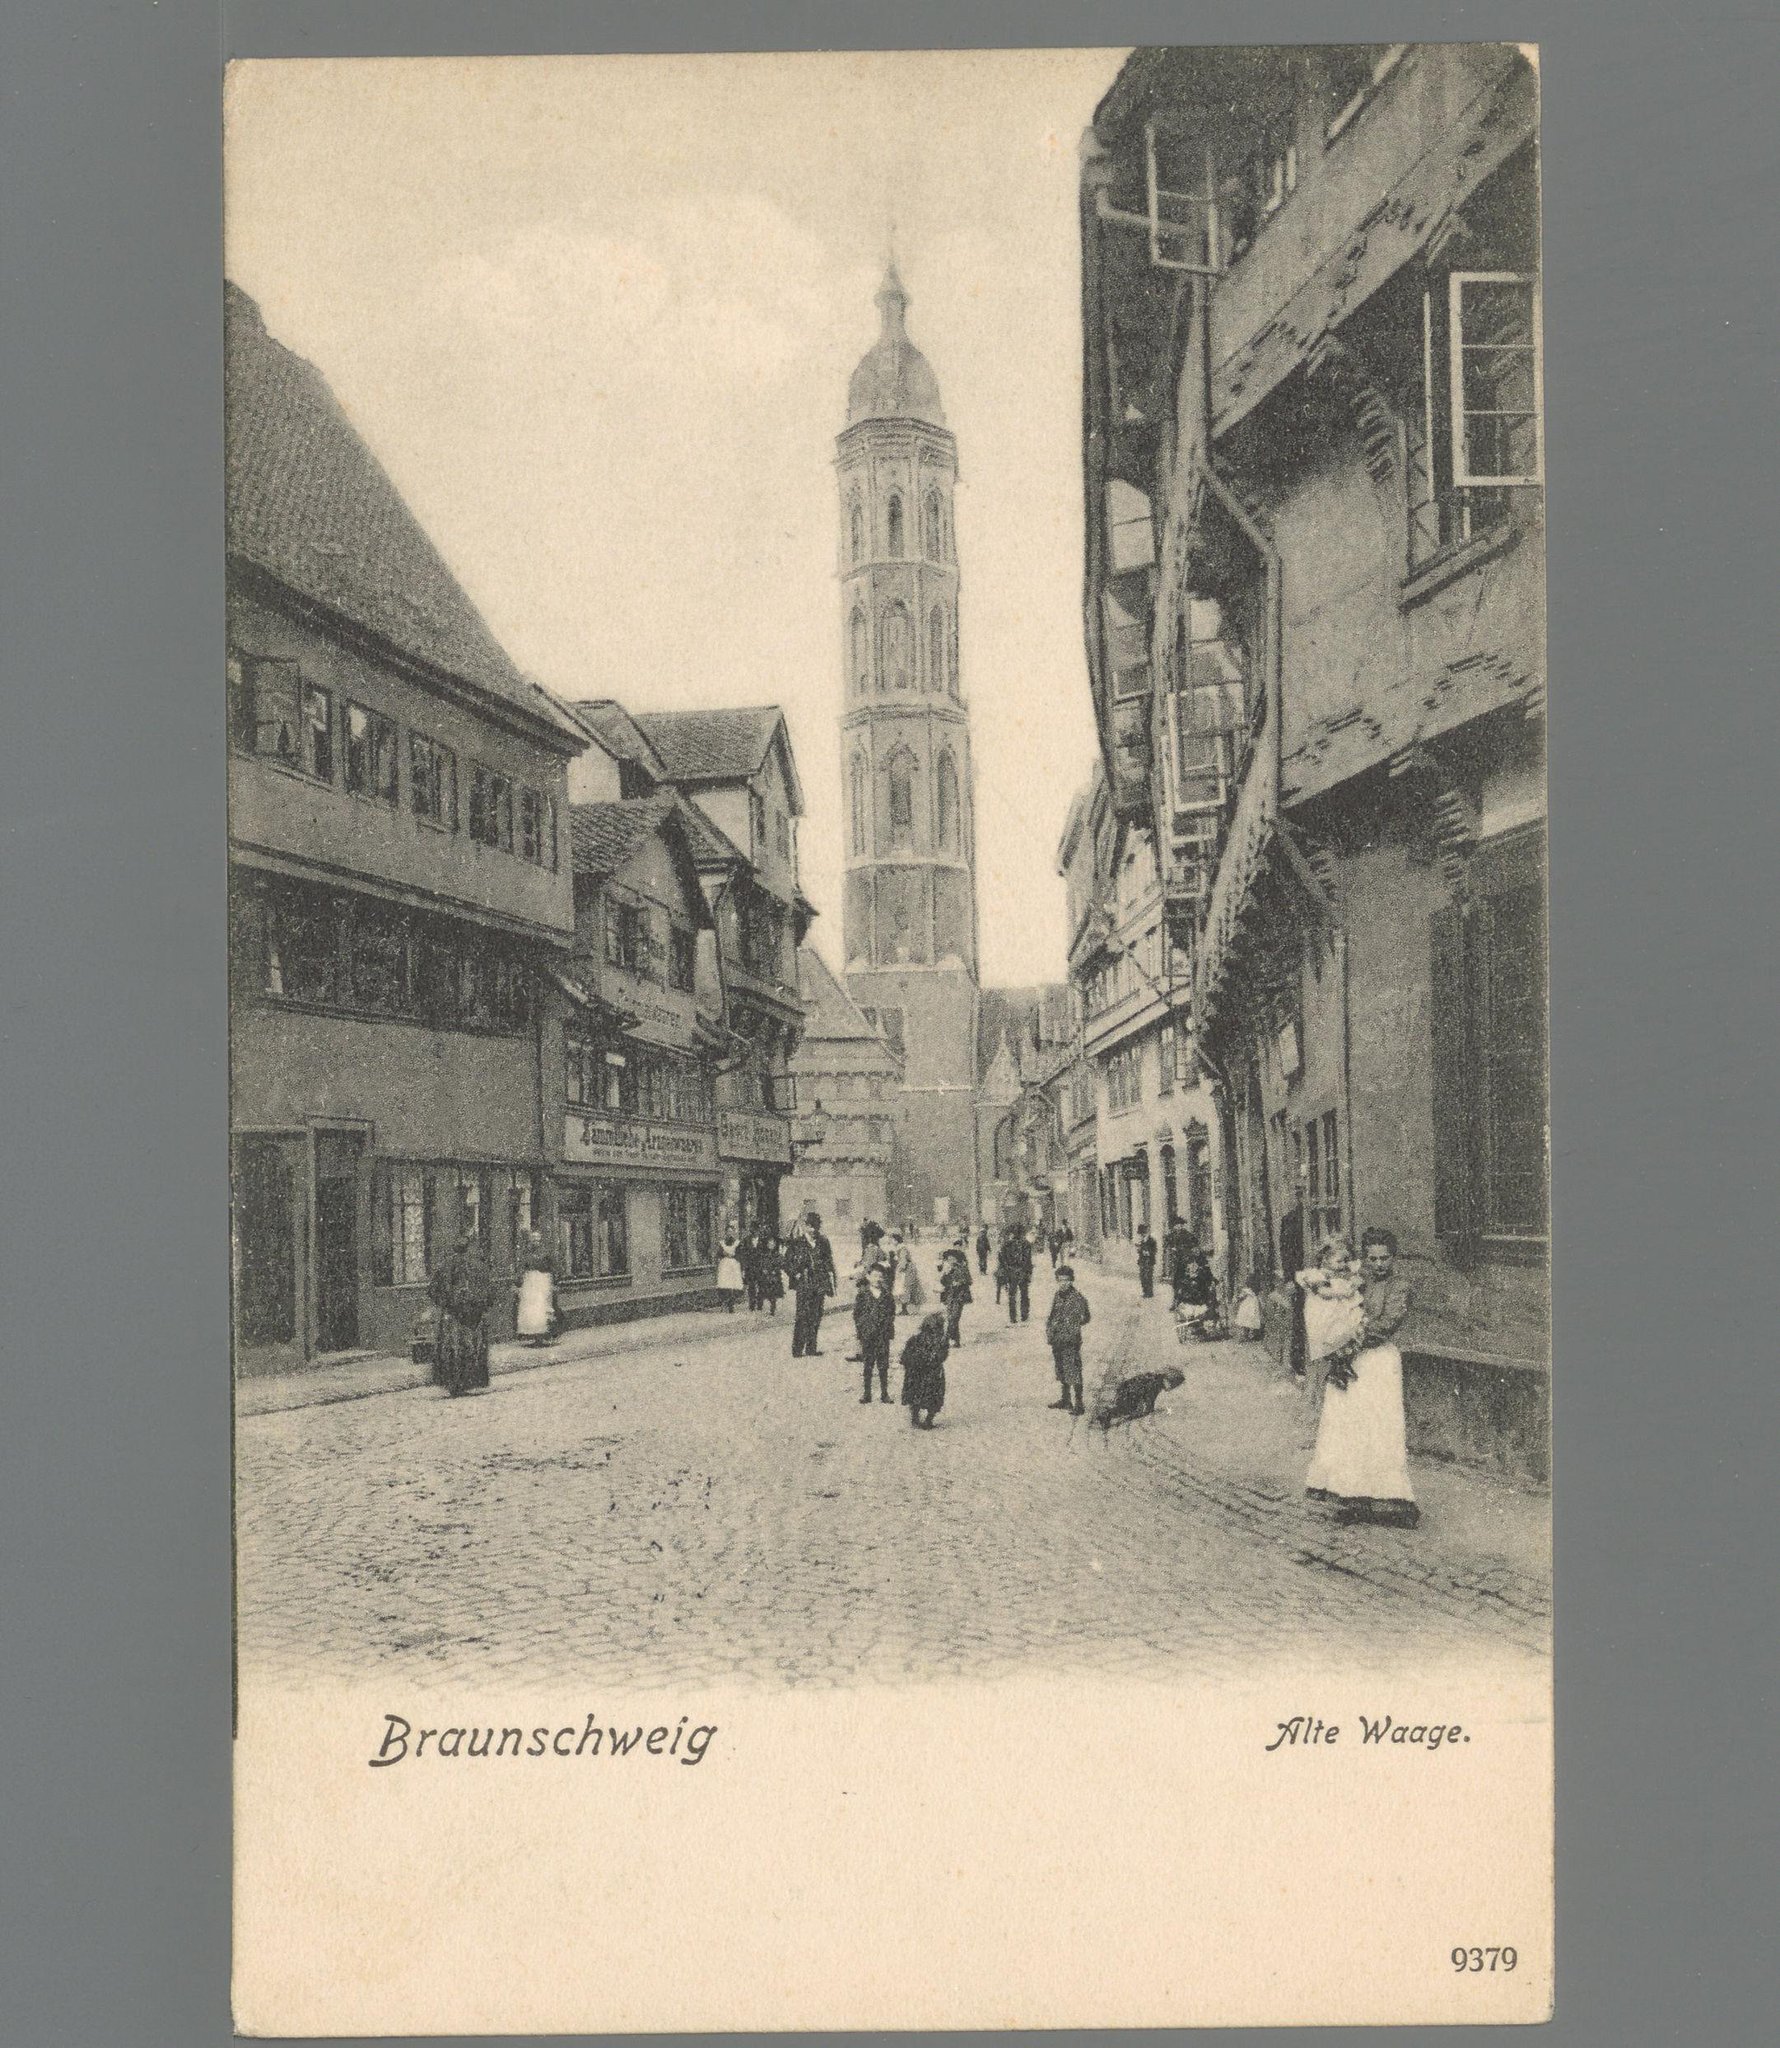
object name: photomechanical print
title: Braunschweig. Alte Waage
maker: Anonymous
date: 1904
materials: cardboard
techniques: photograph, writing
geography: magdeburg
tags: church (exterior), street, weigh-house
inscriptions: postage stamp